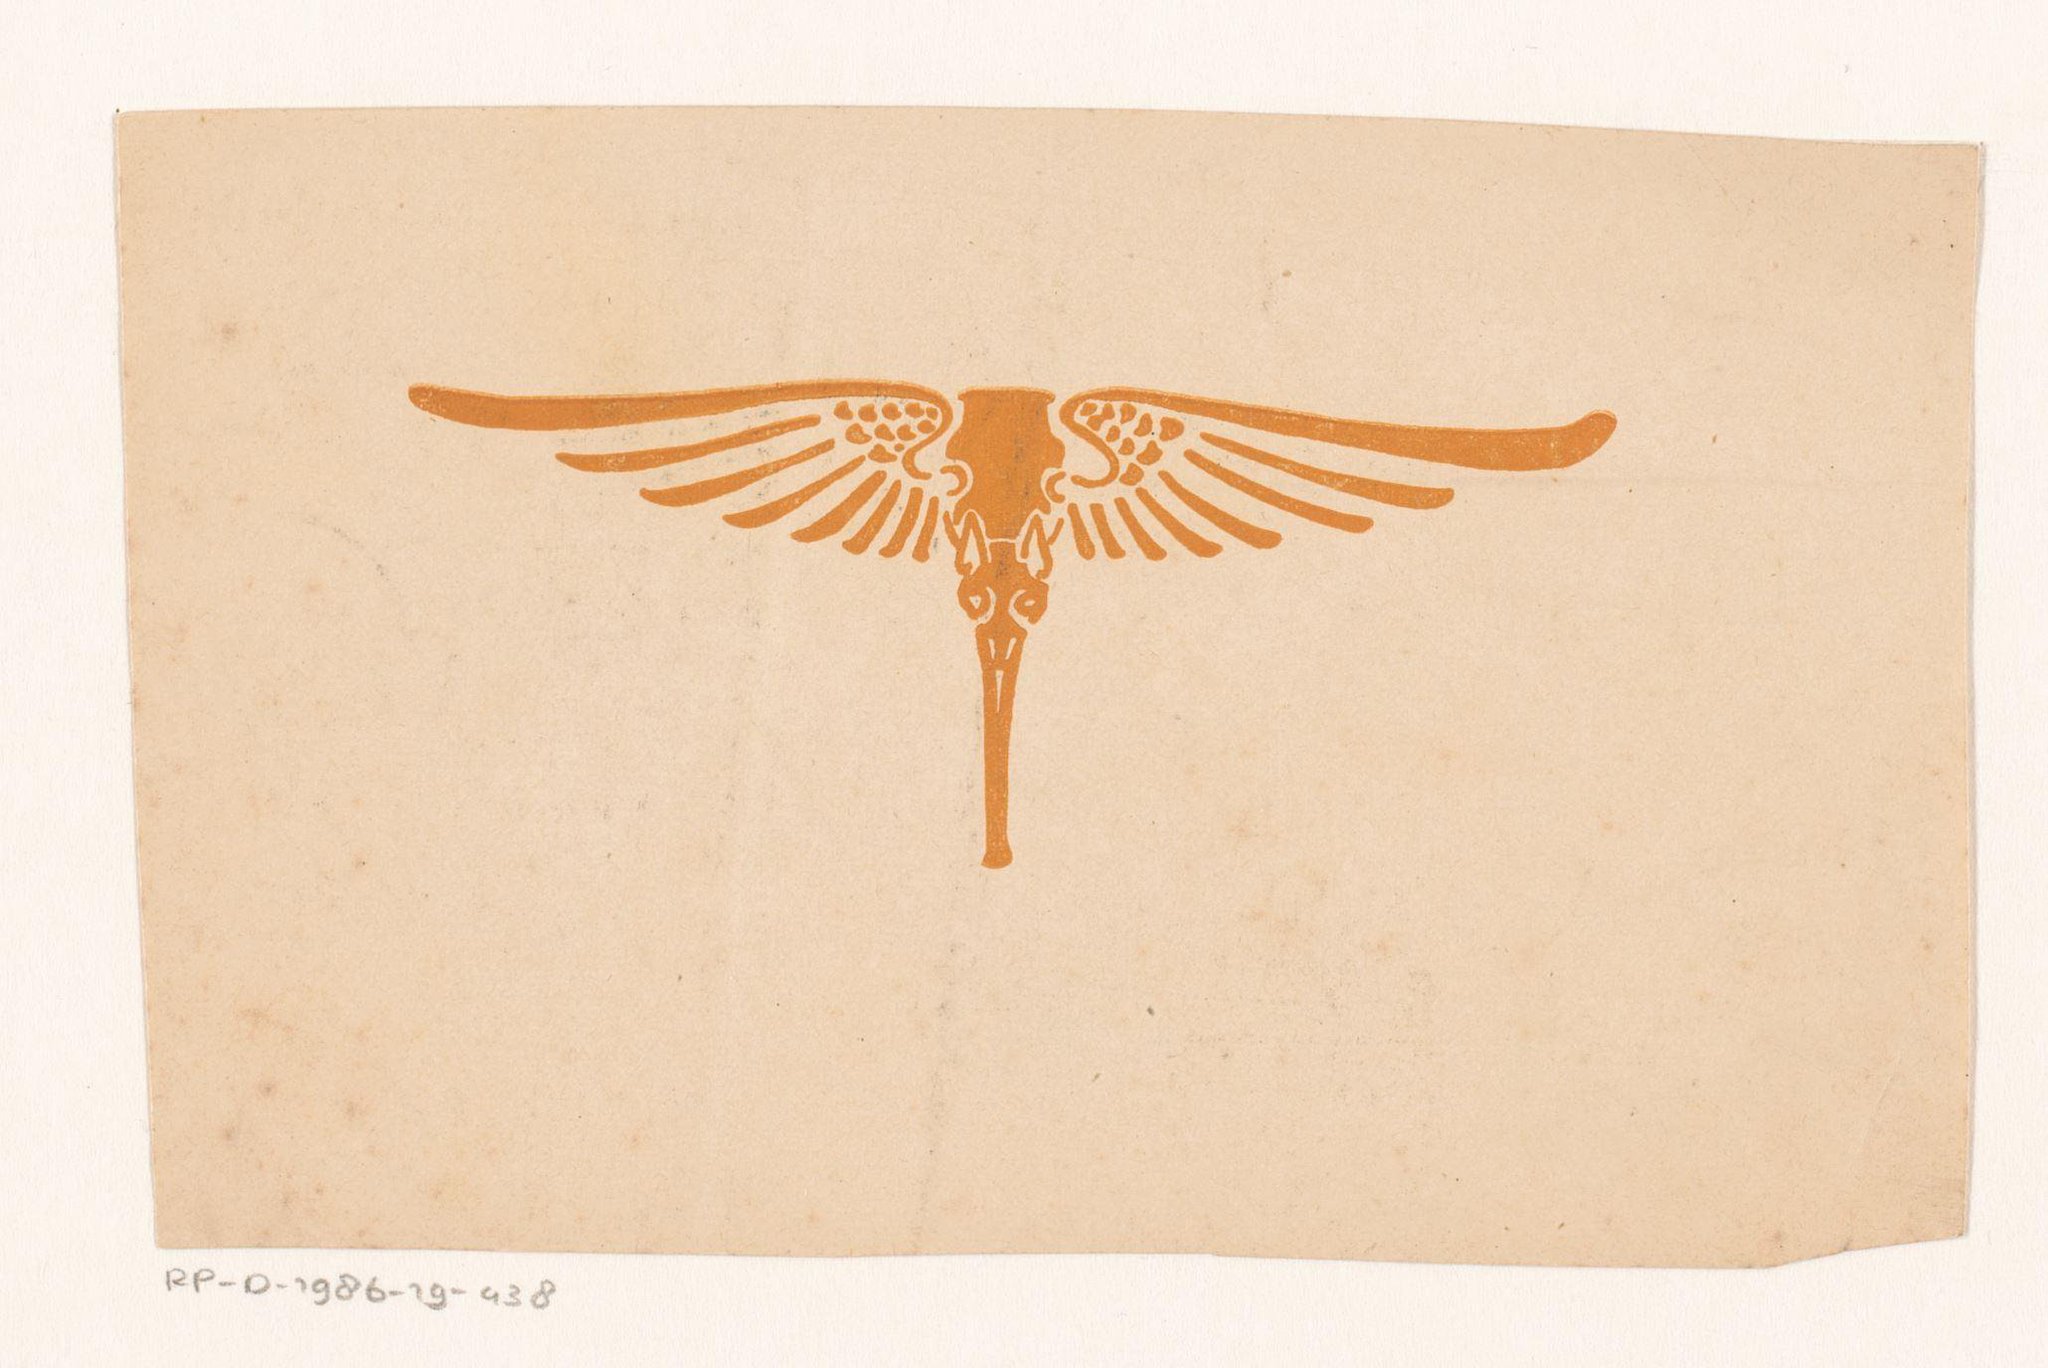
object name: photomechanical print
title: Vignet met gevleugelde staf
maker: reinier willem petrus de vries (1874-1953)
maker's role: draughtsman, print maker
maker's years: 1874-1953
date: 1896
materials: paper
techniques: printing block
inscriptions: collector's mark: ‘R:MVS.’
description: Vignet bedoeld voor: Woord en Beeld. Geïllustreerd maandschrift, 1896.